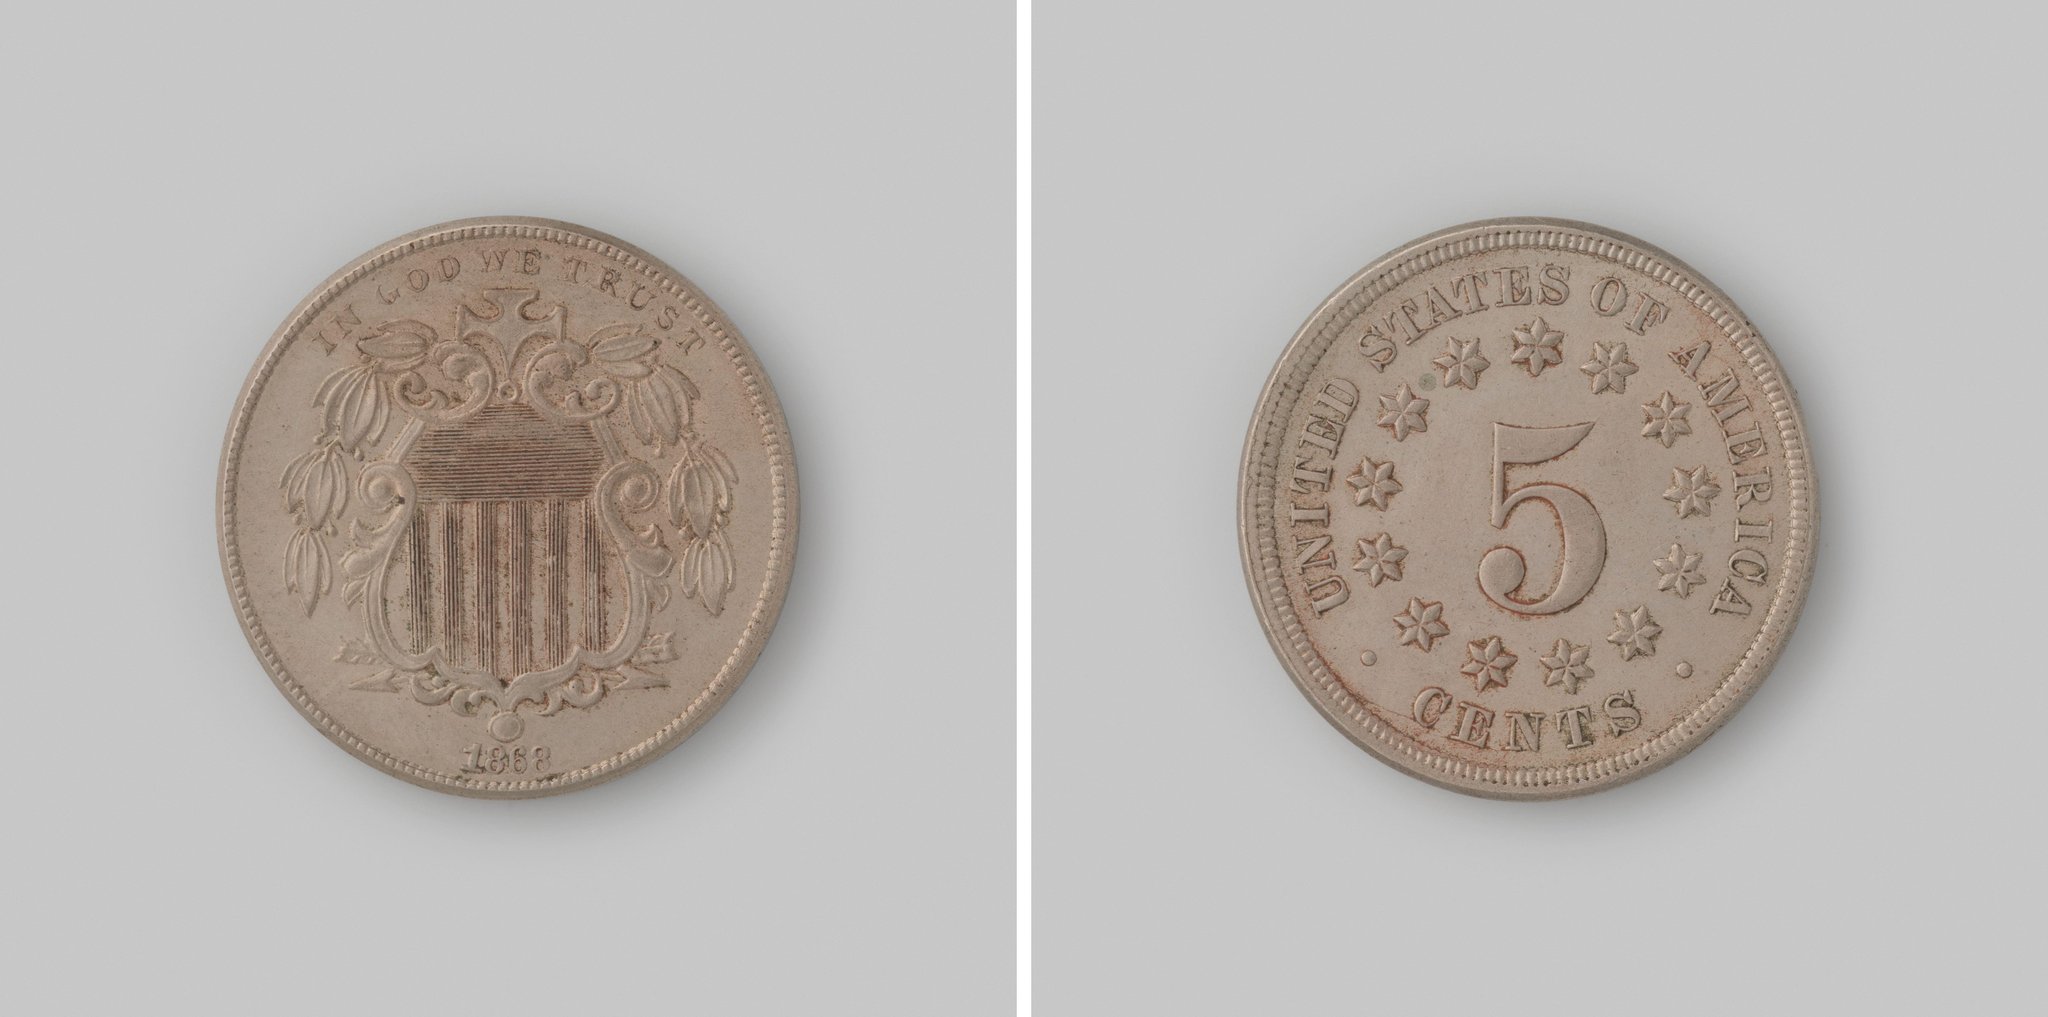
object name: coin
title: Verenigde Staten van Amerika, 5 cents, 1868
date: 1868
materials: nickel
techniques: striking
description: Koper-nikkelen munt. Voorzijde: tussen twee hangende takken ingebogen wapenschild, waaronder twee pijlen. Onderaan jaartal. Keerzijde: waarde-aanduiding: 5 cents in twee regels. Daartussen ring van sterren. Gladde rand.